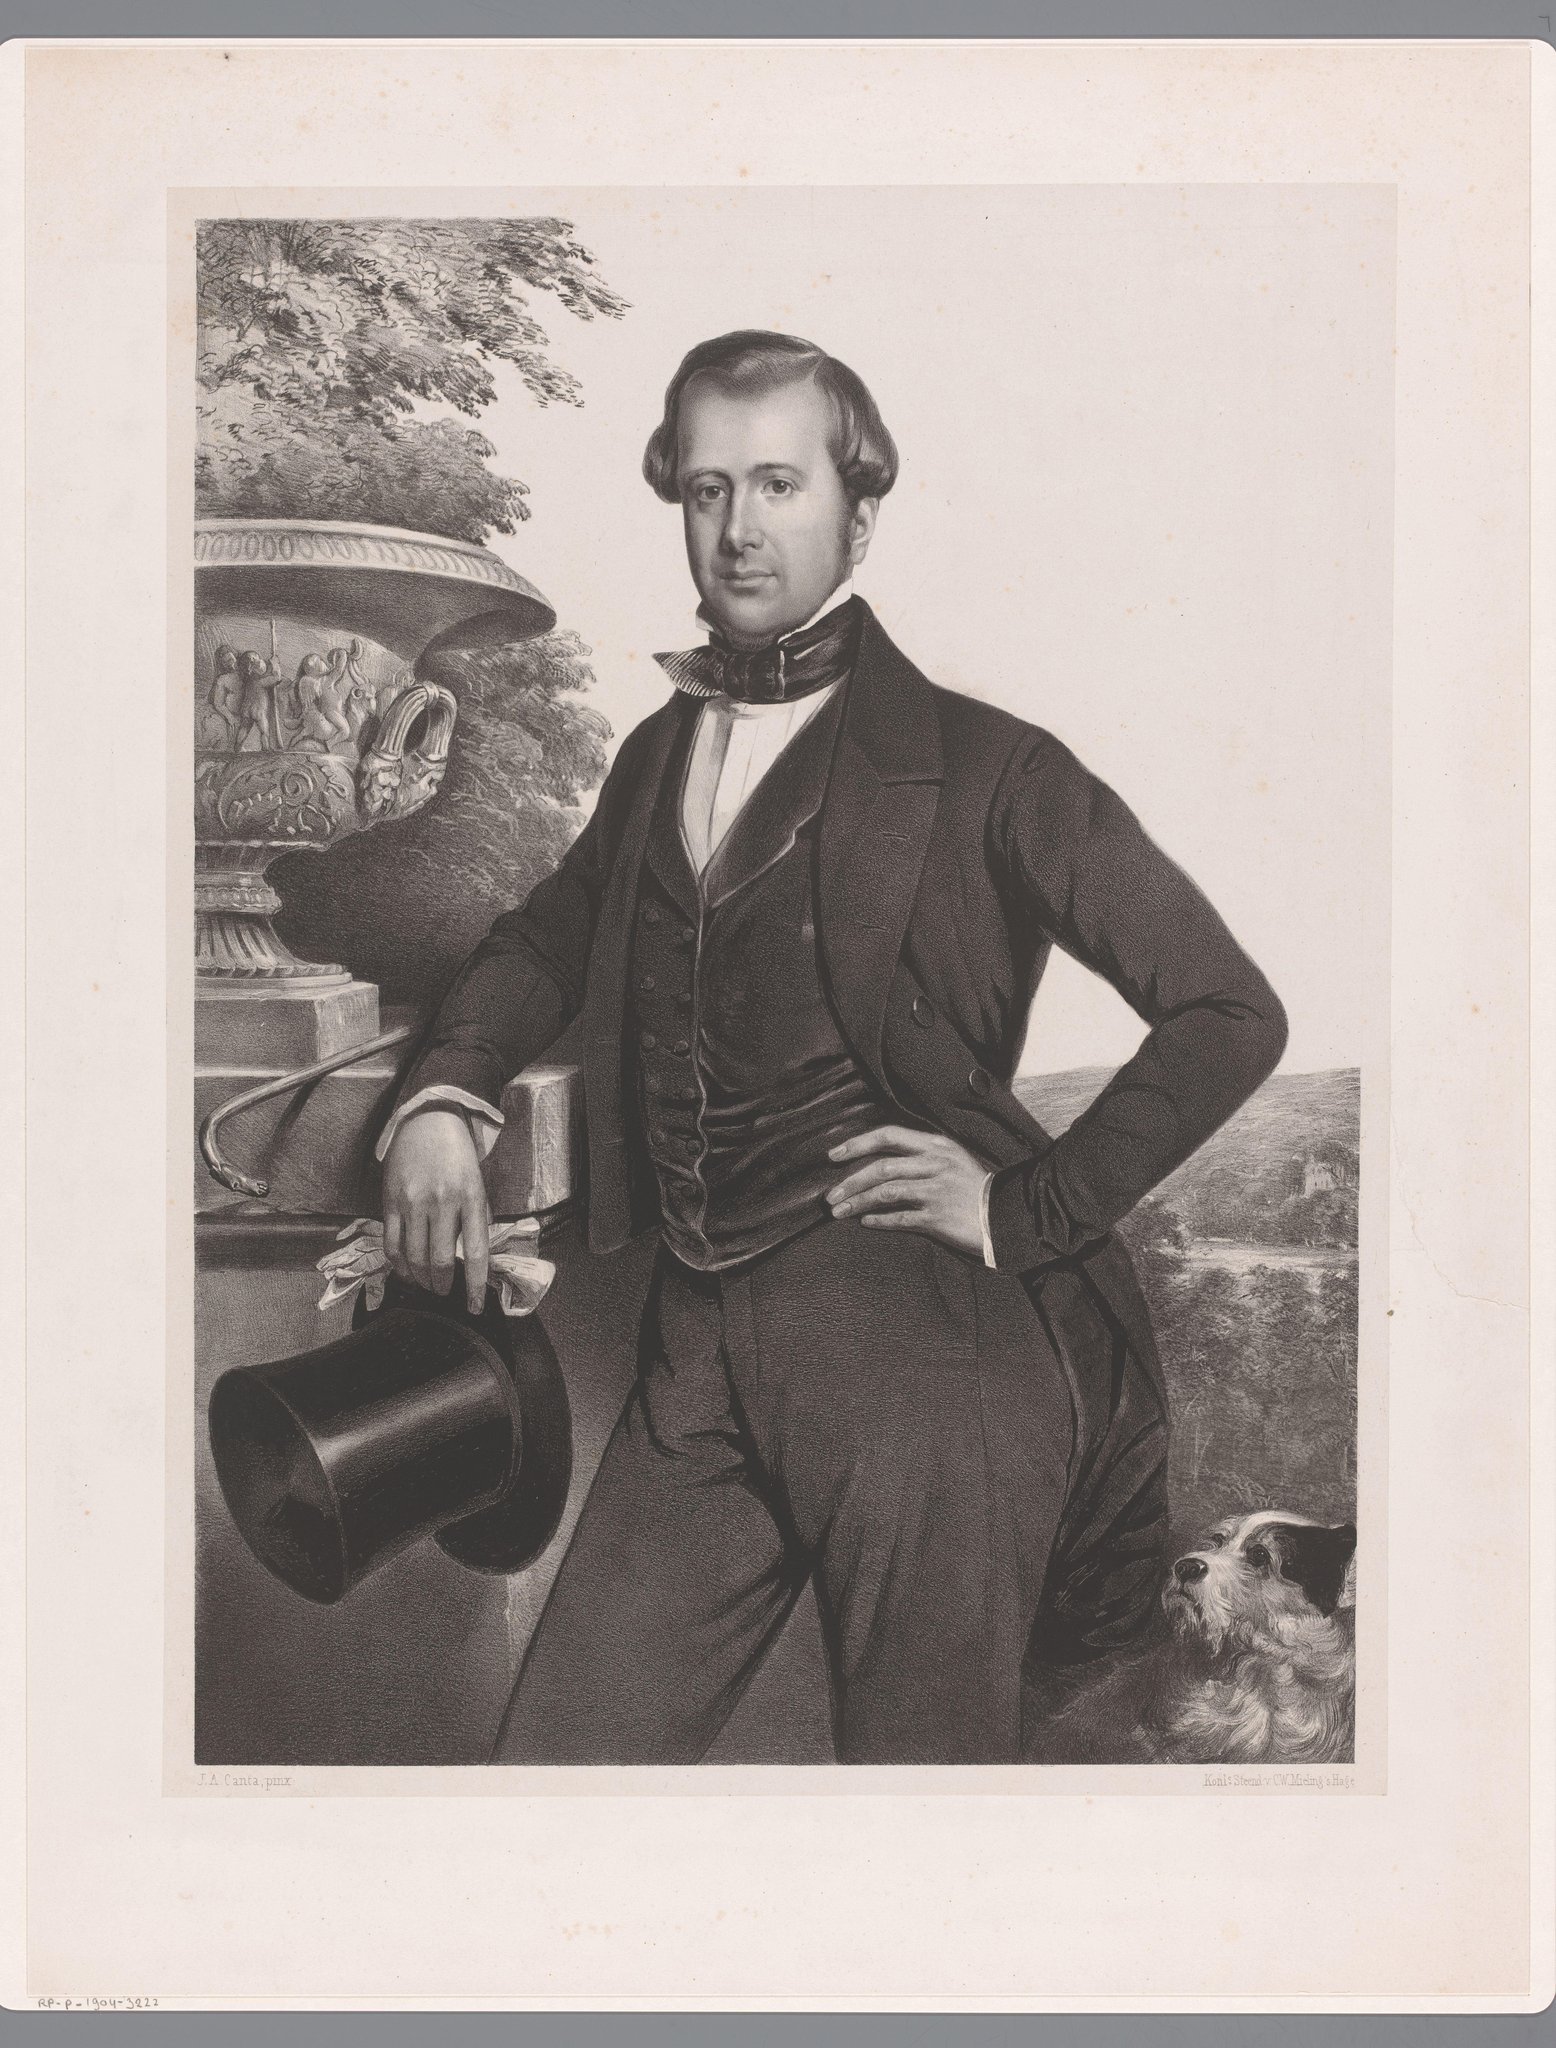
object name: print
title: Portret van een onbekende man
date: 1847-1865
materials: paper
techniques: lithograph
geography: the hague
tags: gloves, mittens, etc., walking-stick, staff, dog, historical persons (+ three-quarter length portrait), garden vase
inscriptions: collector's mark: Lugt 2228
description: De man heeft zijn hoge hoed en handschoenen in zijn rechterhand. Hij leunt tegen een muur met daarop zijn wandelstok en een tuinvaas. Rechts van hem zit een hond.